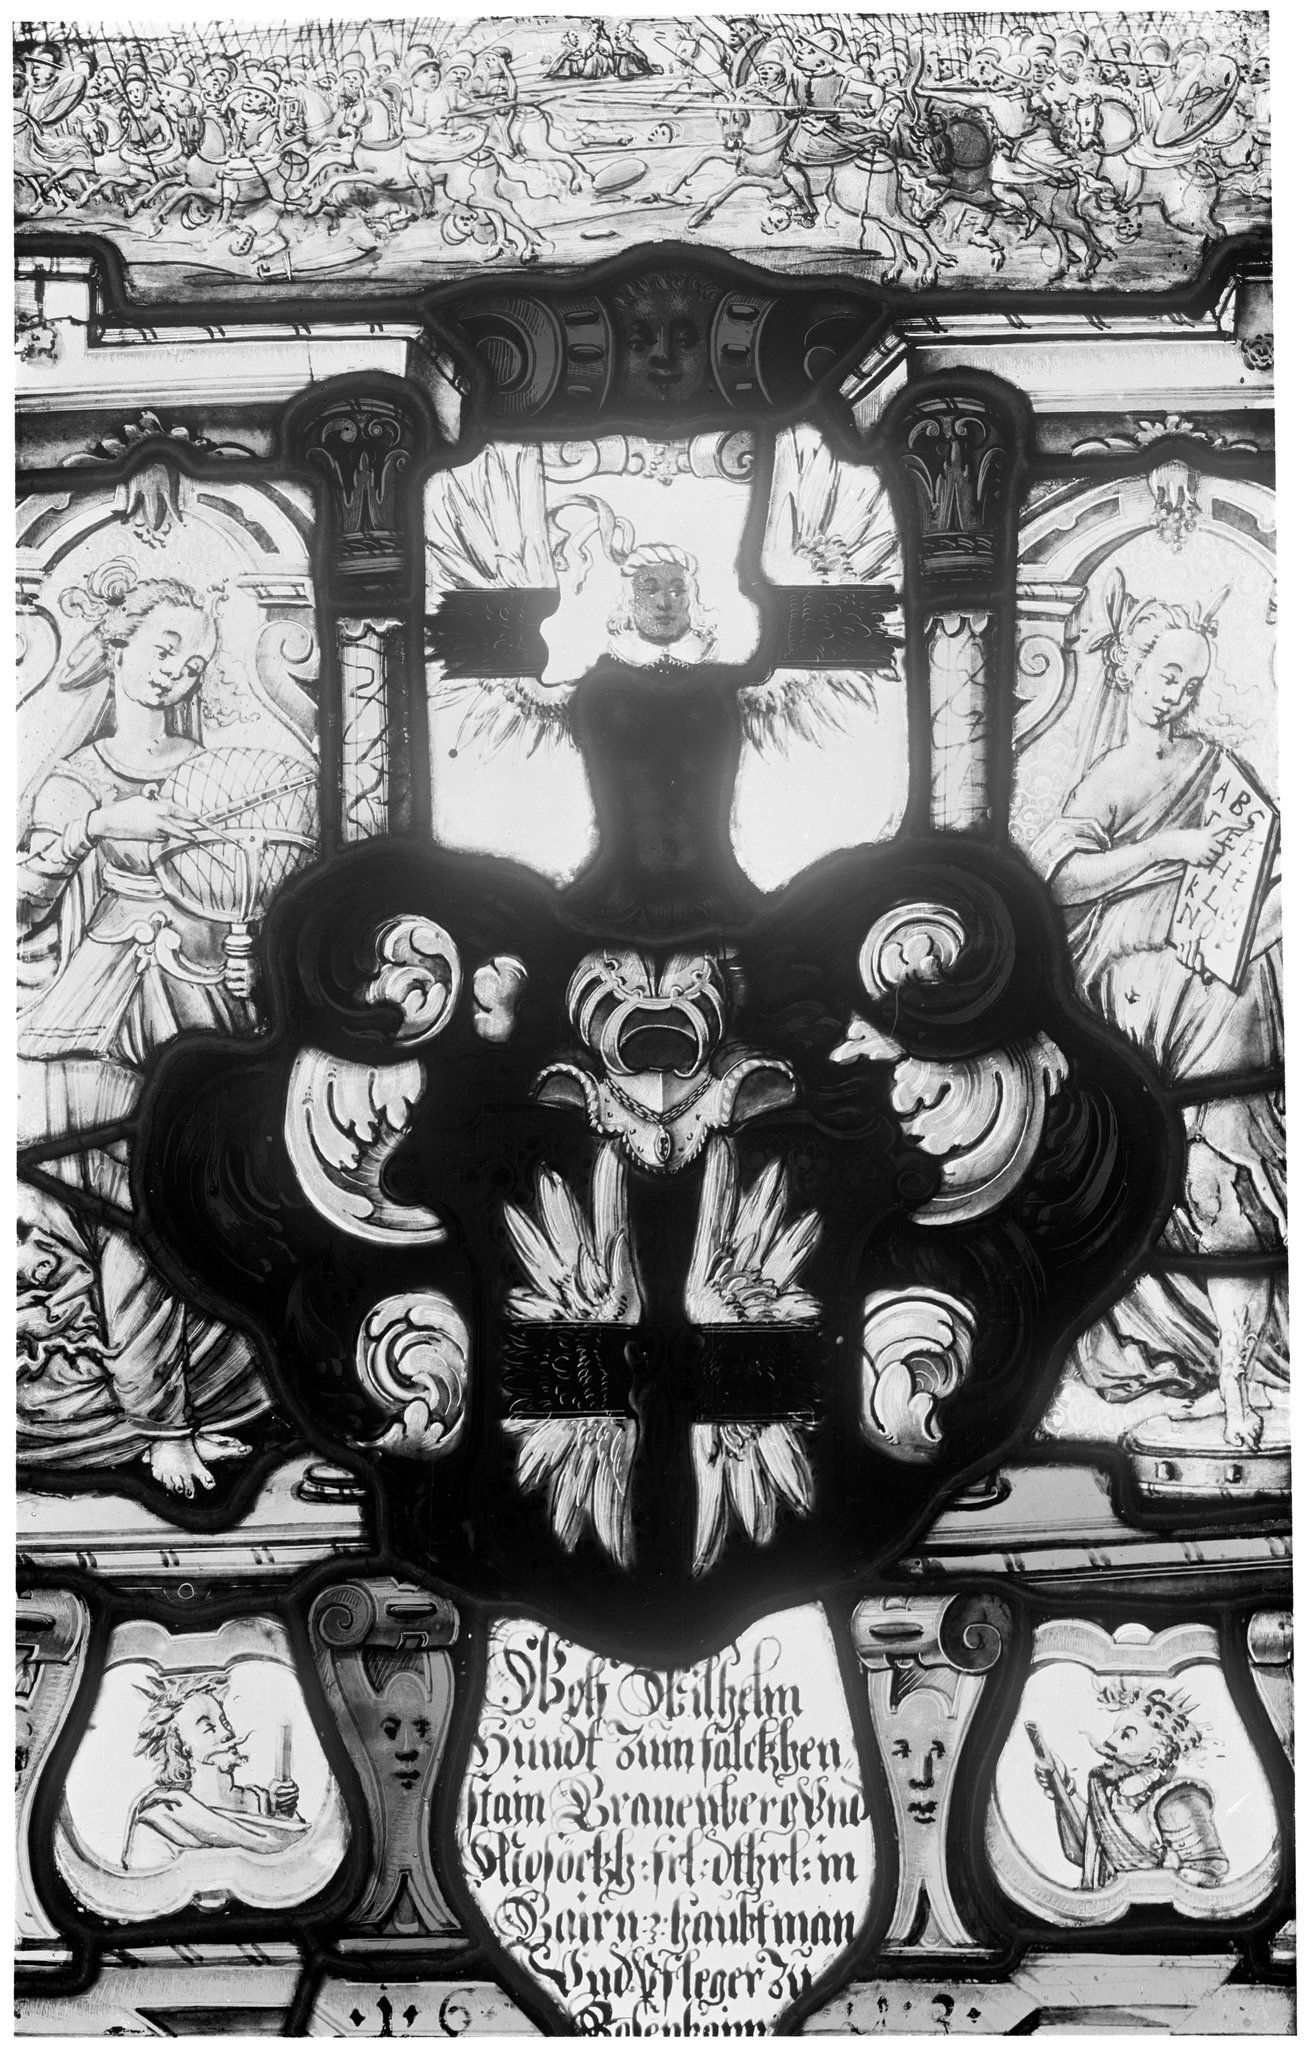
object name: panel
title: Battle scene and allegorical figures with the armorial of Wilhelm Hundt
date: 1603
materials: glass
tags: human figures,battles,horses